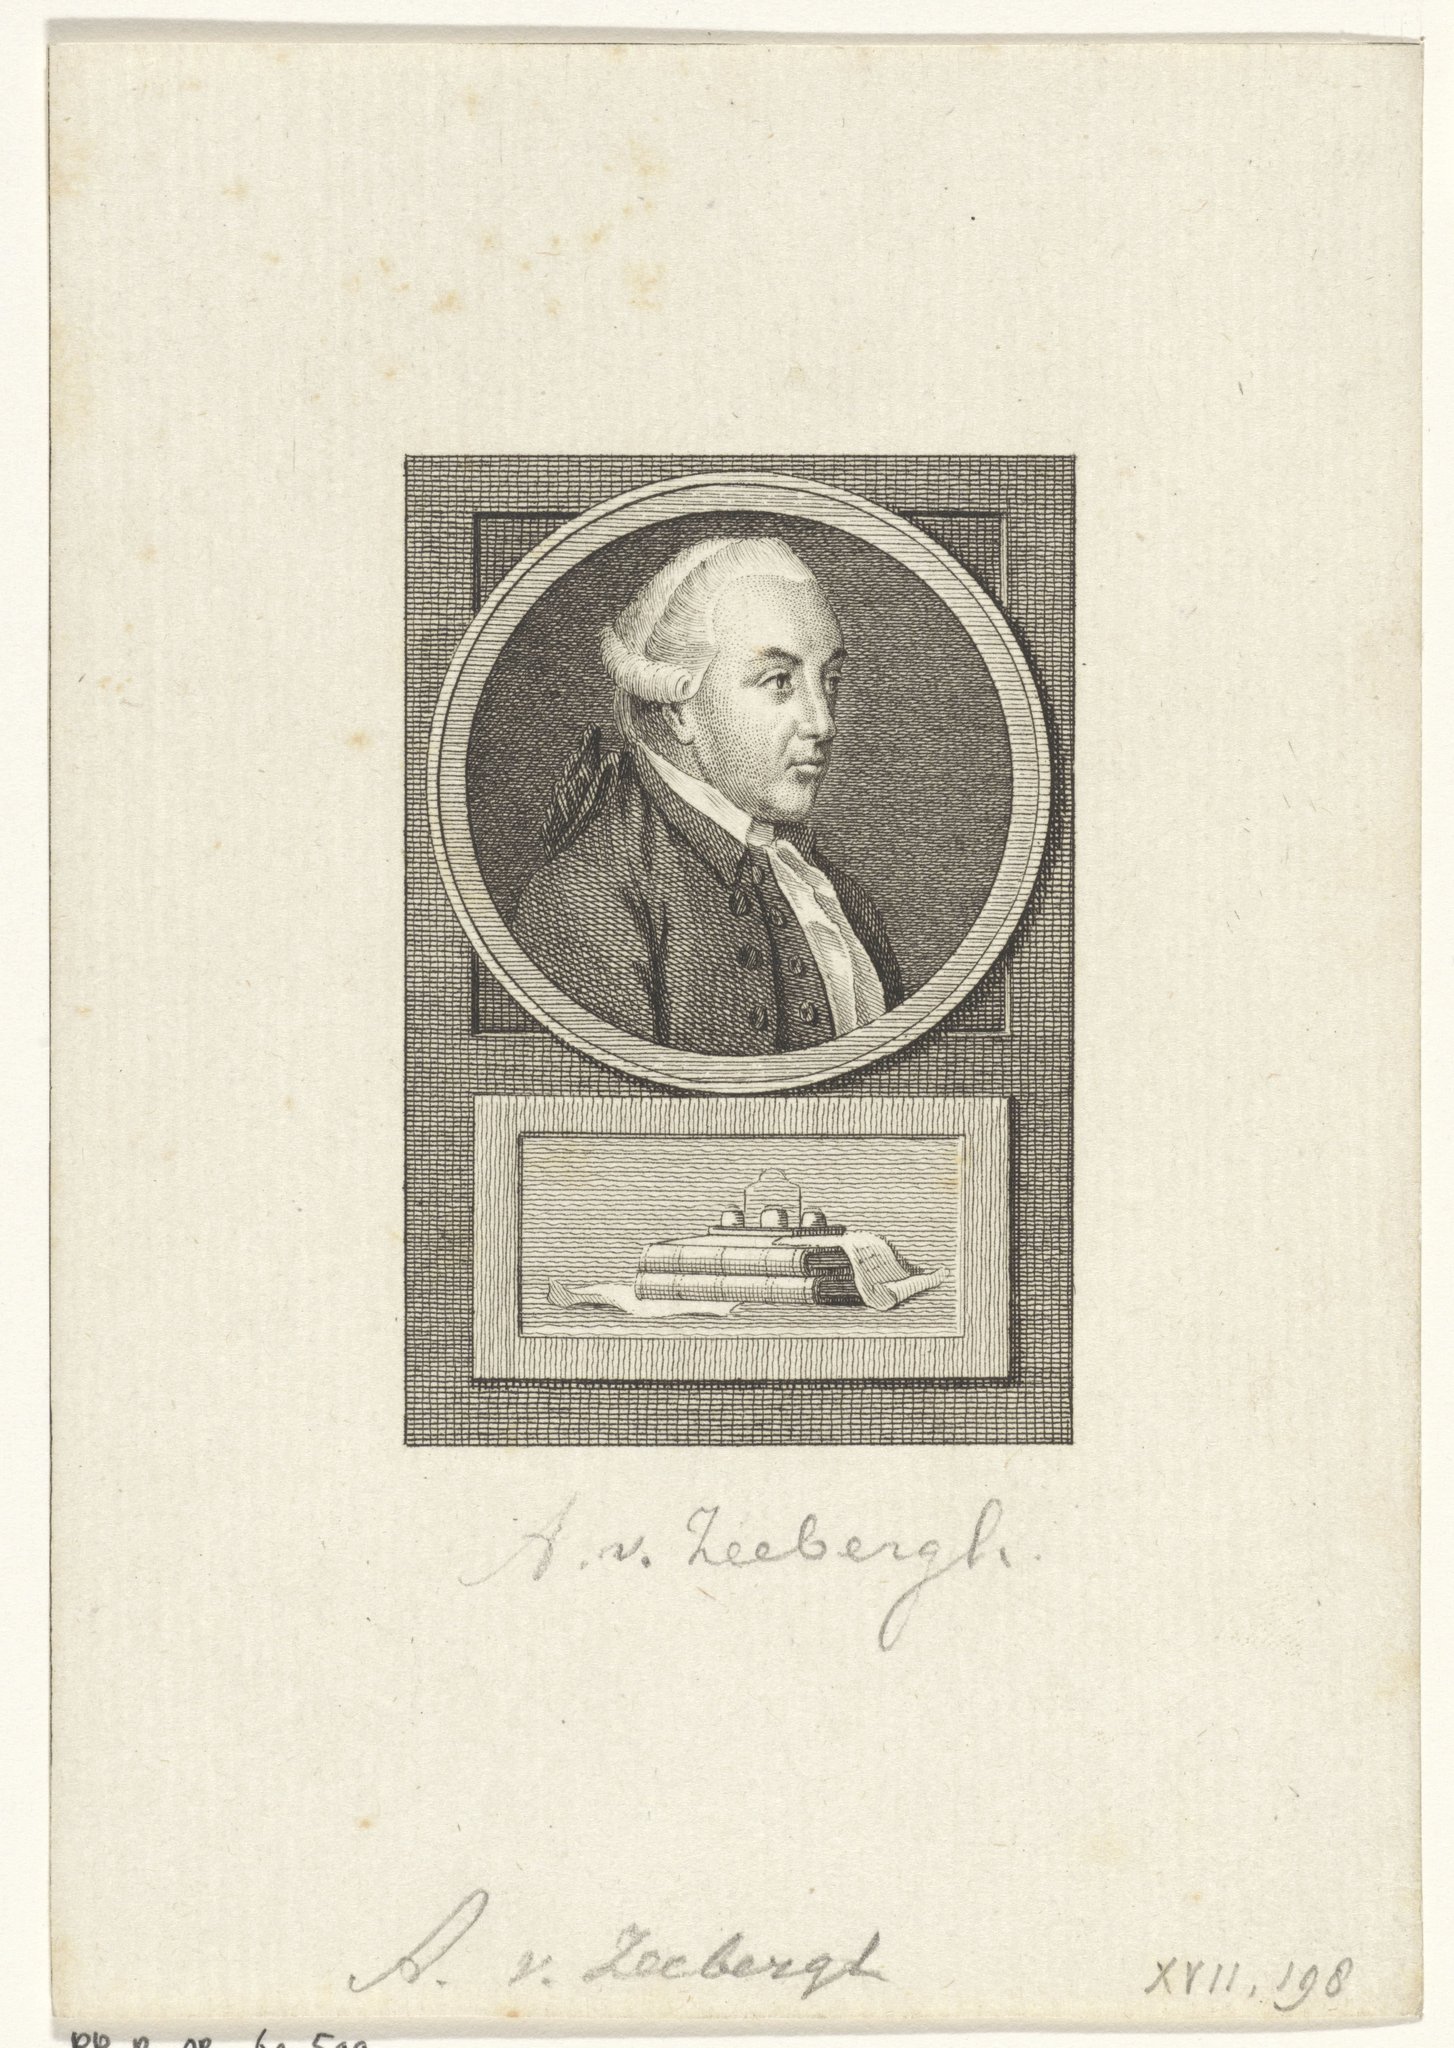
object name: print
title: Portret van Adriaan van Zeebergh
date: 1783-1795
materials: paper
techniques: engraving, etching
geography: amsterdam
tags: ink-well, book, paper (writing material)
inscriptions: collector's mark: Lugt 2228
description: Later staat prent gebruikt in: Fokke, Jan. Geschiedenissen der Vereenigde Nederlanden voor de vaderlandsche jeugd Ie-XXVste deel. Amsterdam: Johannes Allart, 1783-1795. Deel XVII.